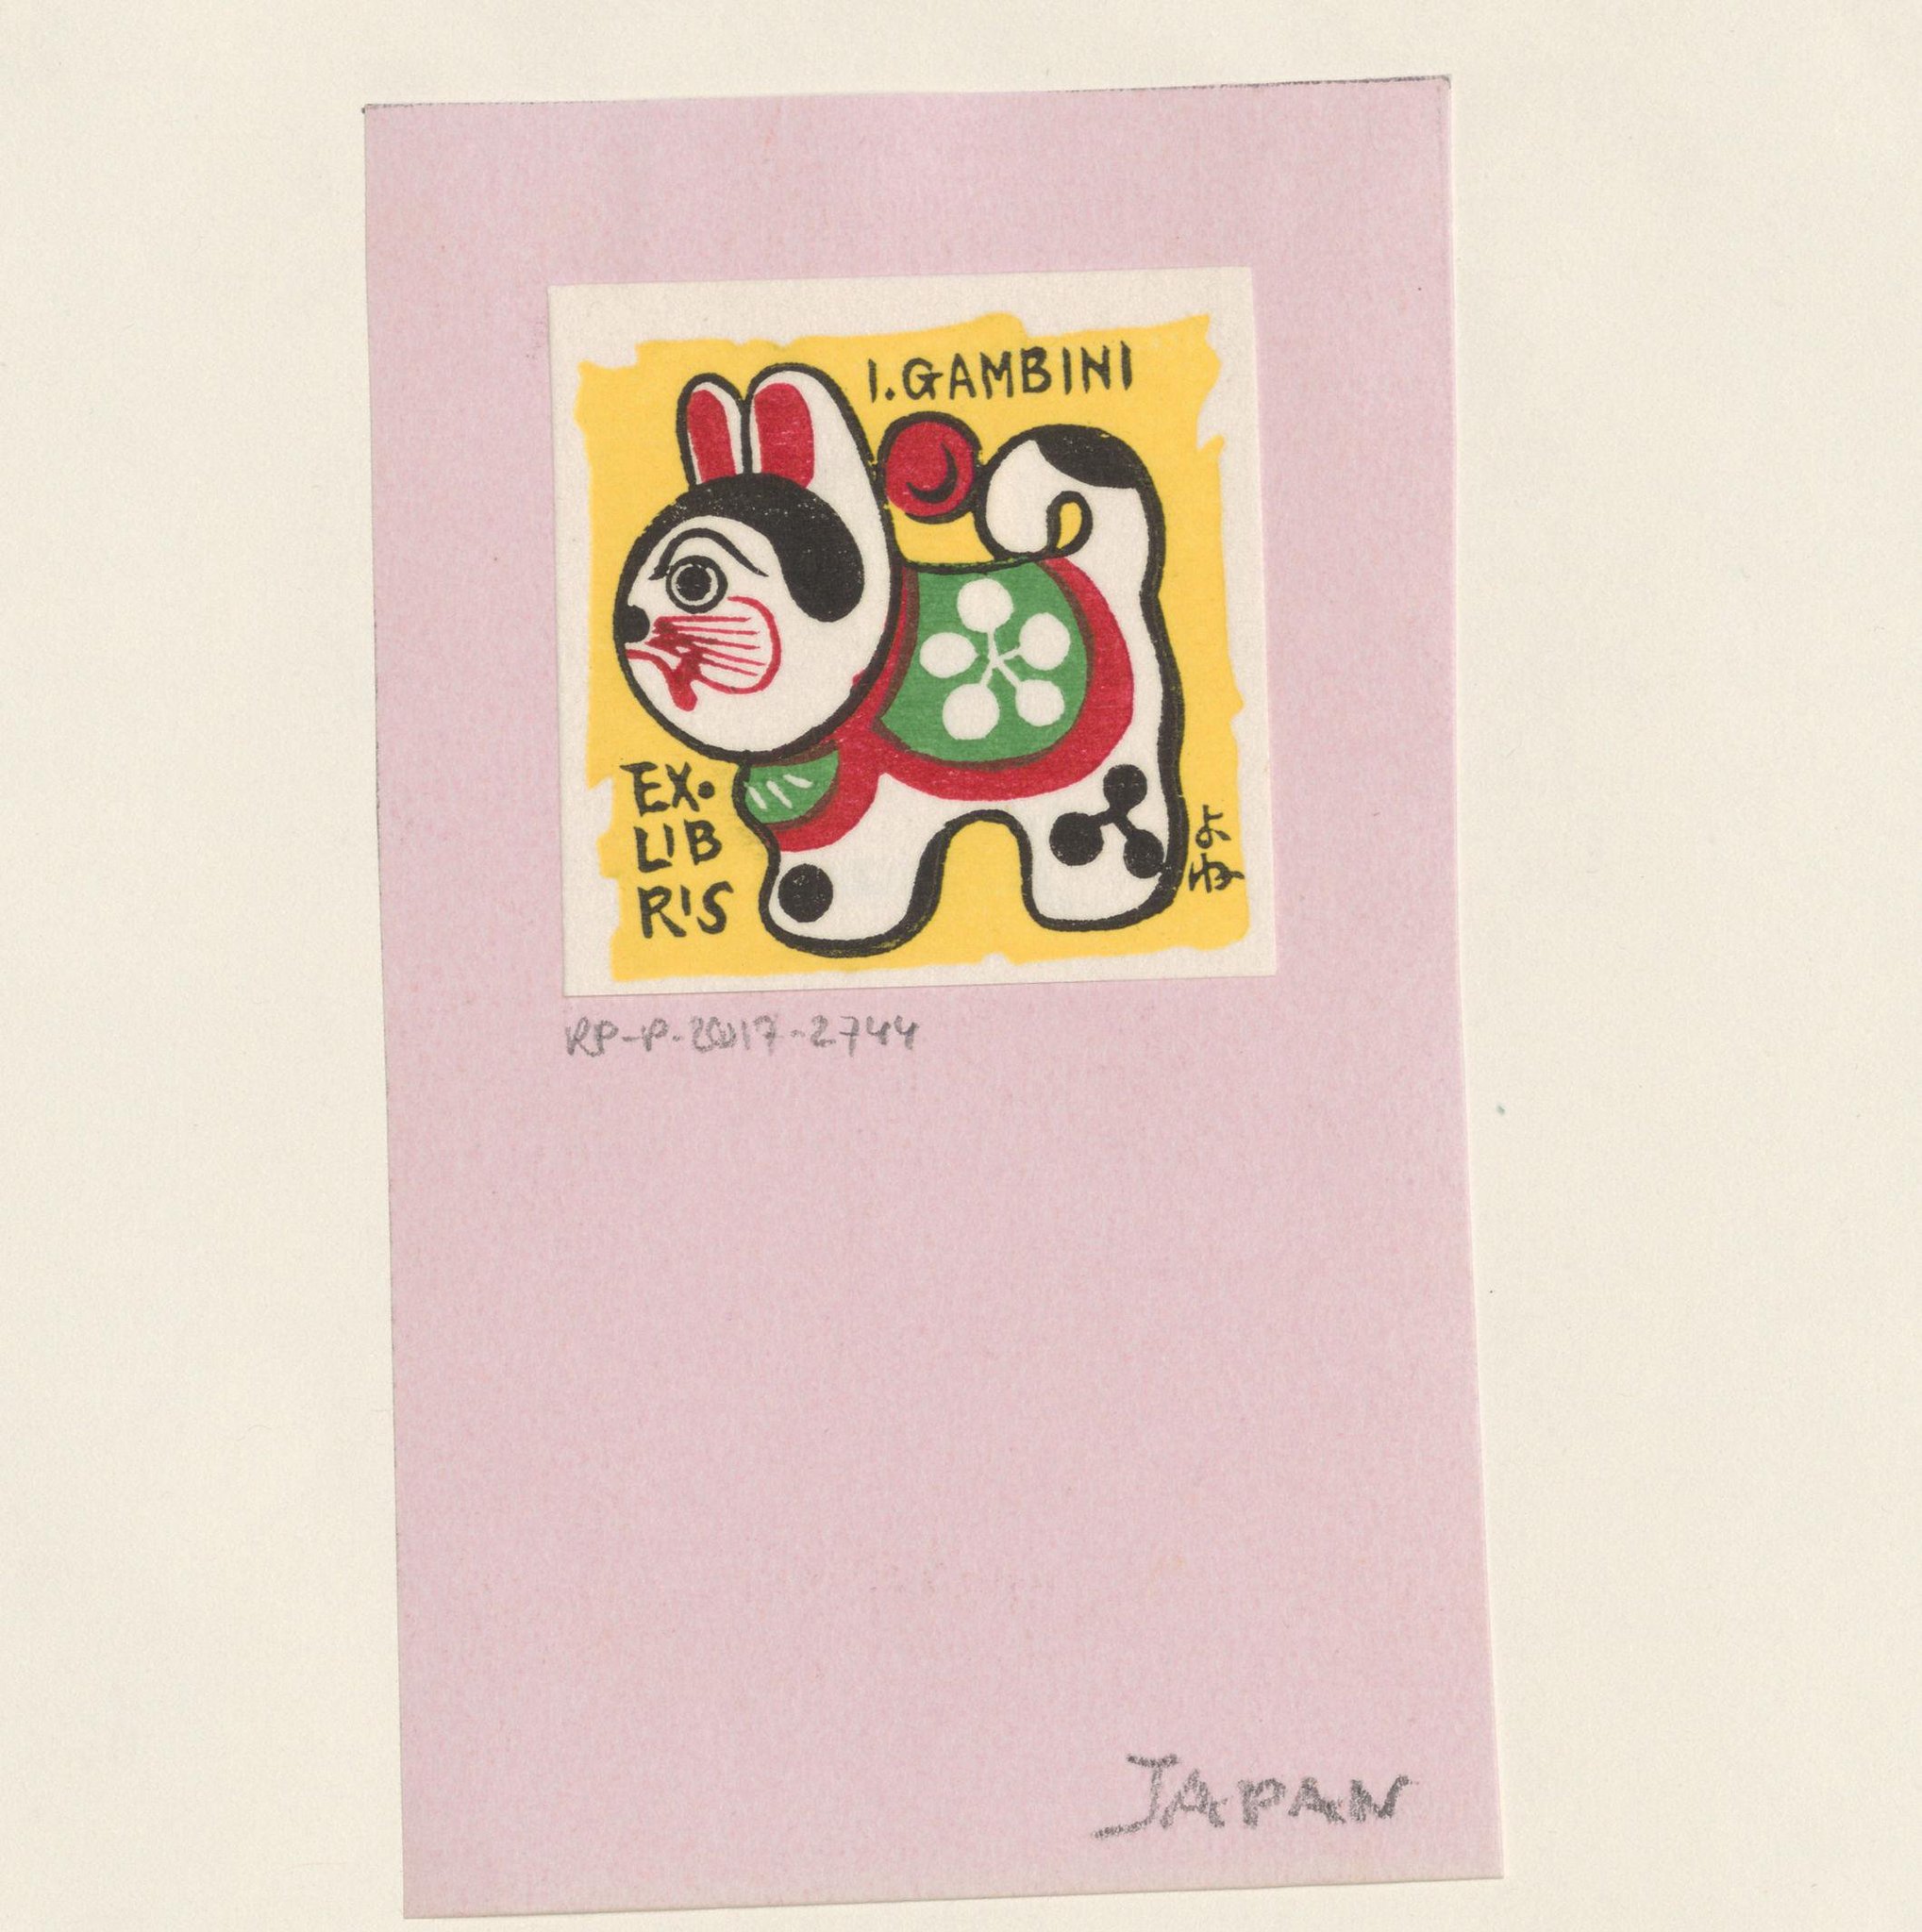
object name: bookplate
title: Ex libris van I. Gambini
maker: Anonymous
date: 1900-1999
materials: paper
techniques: woodcut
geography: japan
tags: print maker, iörg gambini, cat